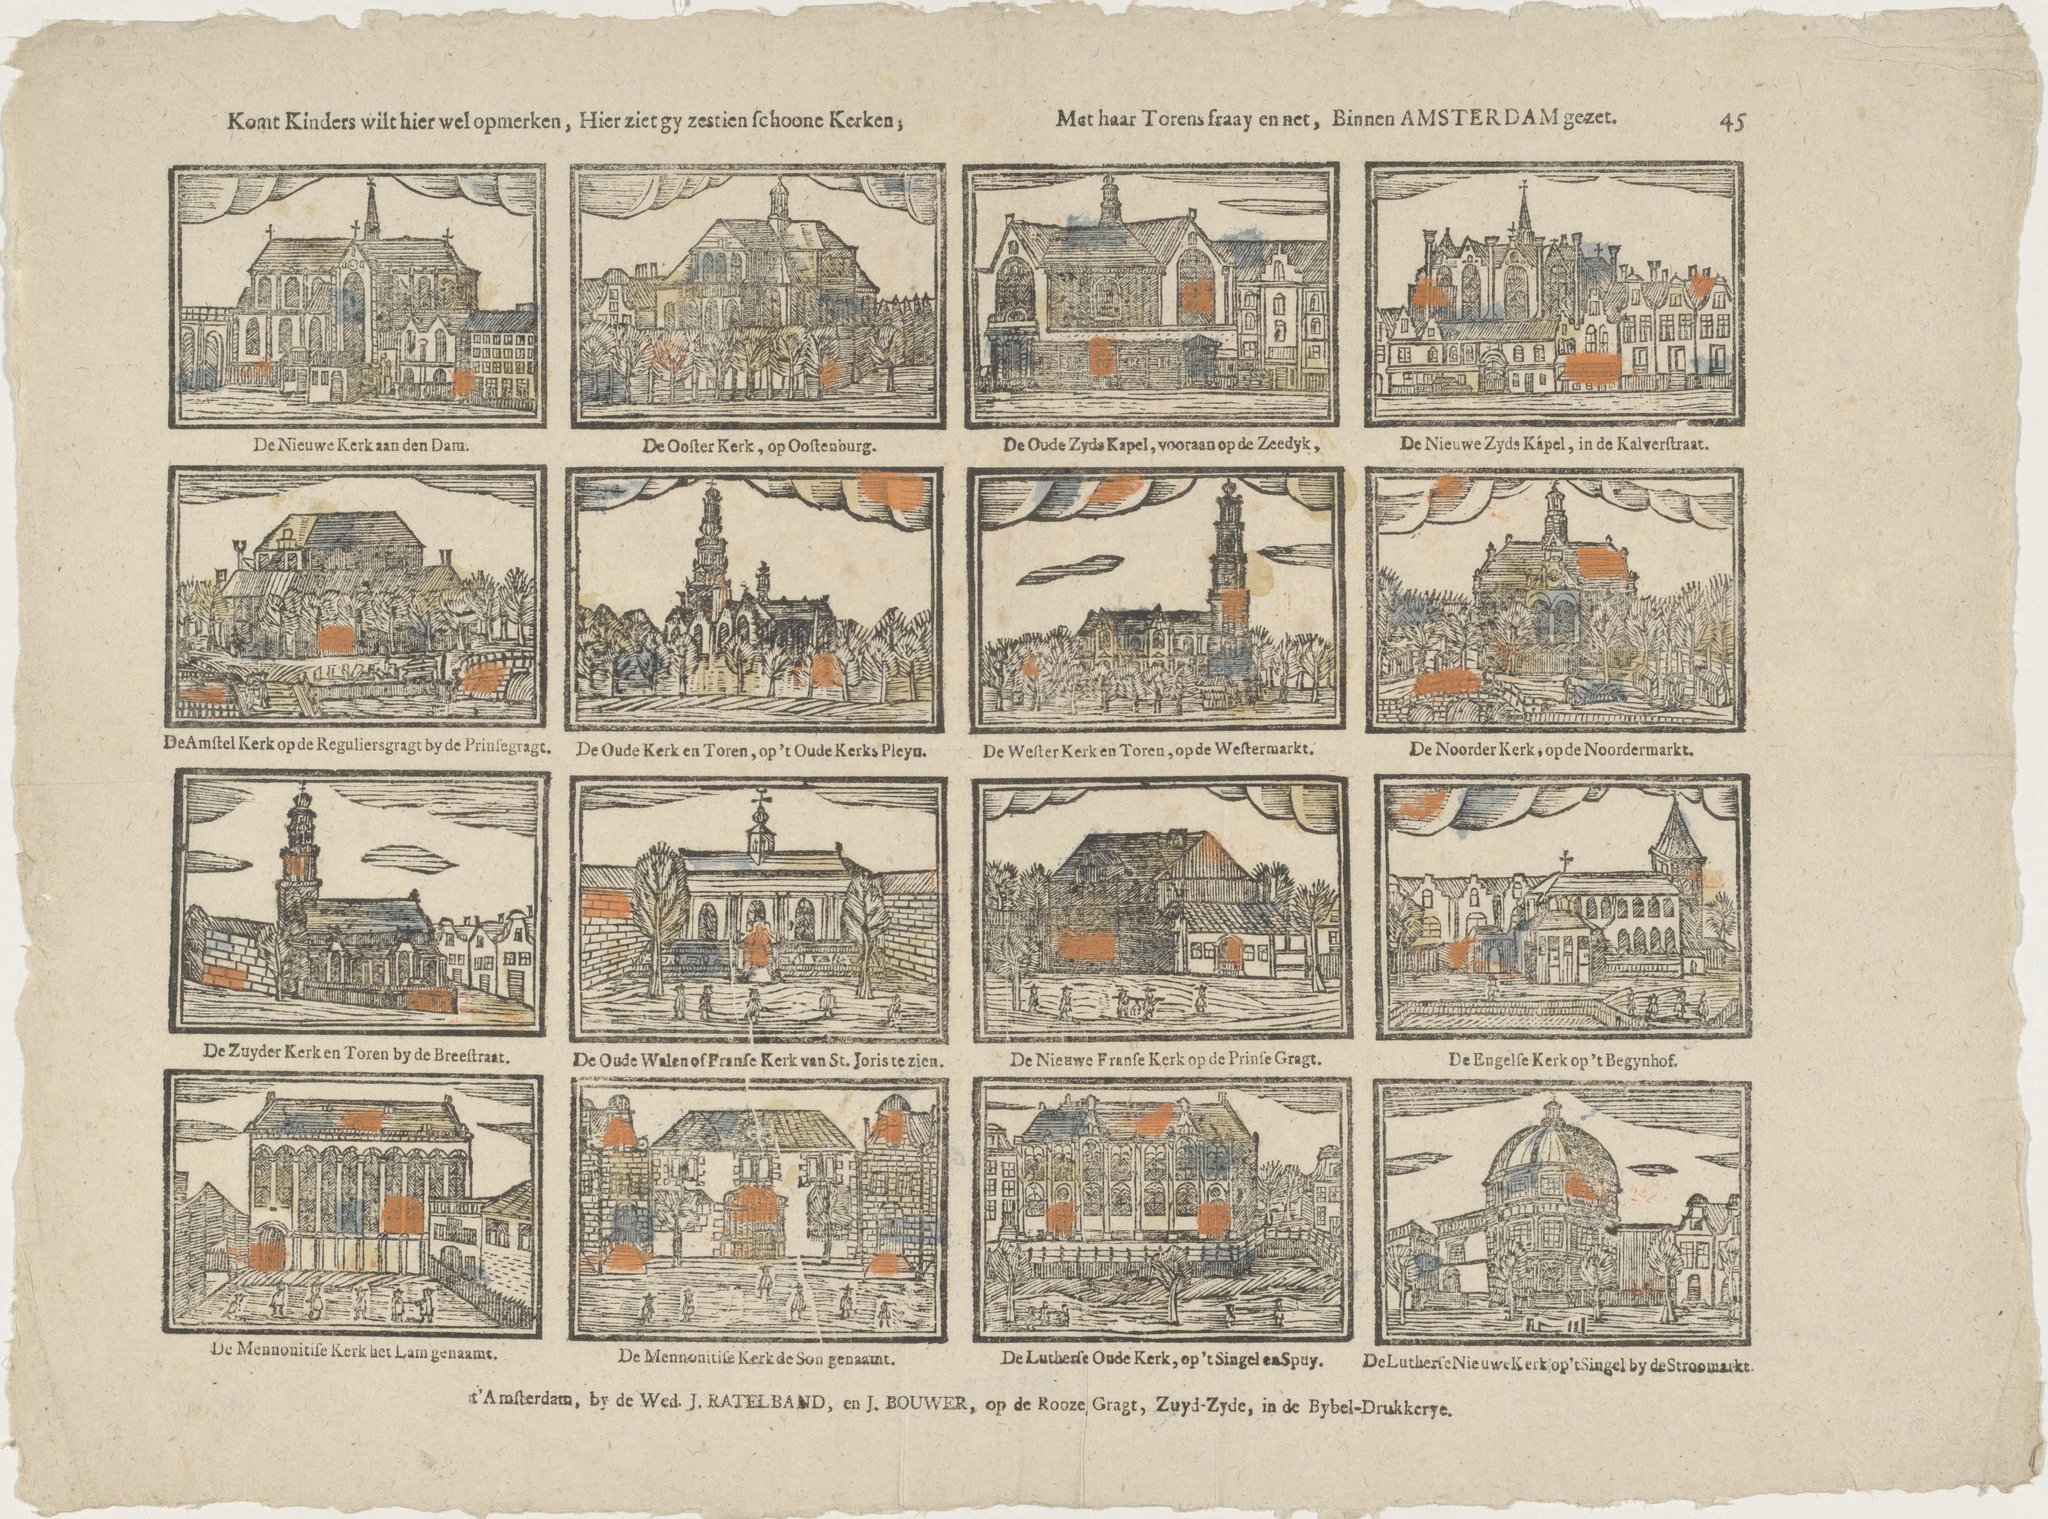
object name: popular print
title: Komt kinders wilt hier wel op merken, Hier ziet gy zestien schoone kerken; / Met haar torens fraay en net, Binnen Amsterdam gezet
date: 1767-1778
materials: paper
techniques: colour, letterpress printing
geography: amsterdam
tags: church (exterior), amsterdam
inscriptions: collector's mark: Lugt 2228, collector's mark: Lugt 2760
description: Blad met 16 voorstellingen van kerken in Amsterdam, zoals de Nieuwe kerk, de Ronde Lutherse kerk en de Noorderkerk. Onder elke voorstelling een onderschrift. Genummerd rechtsboven: 45.